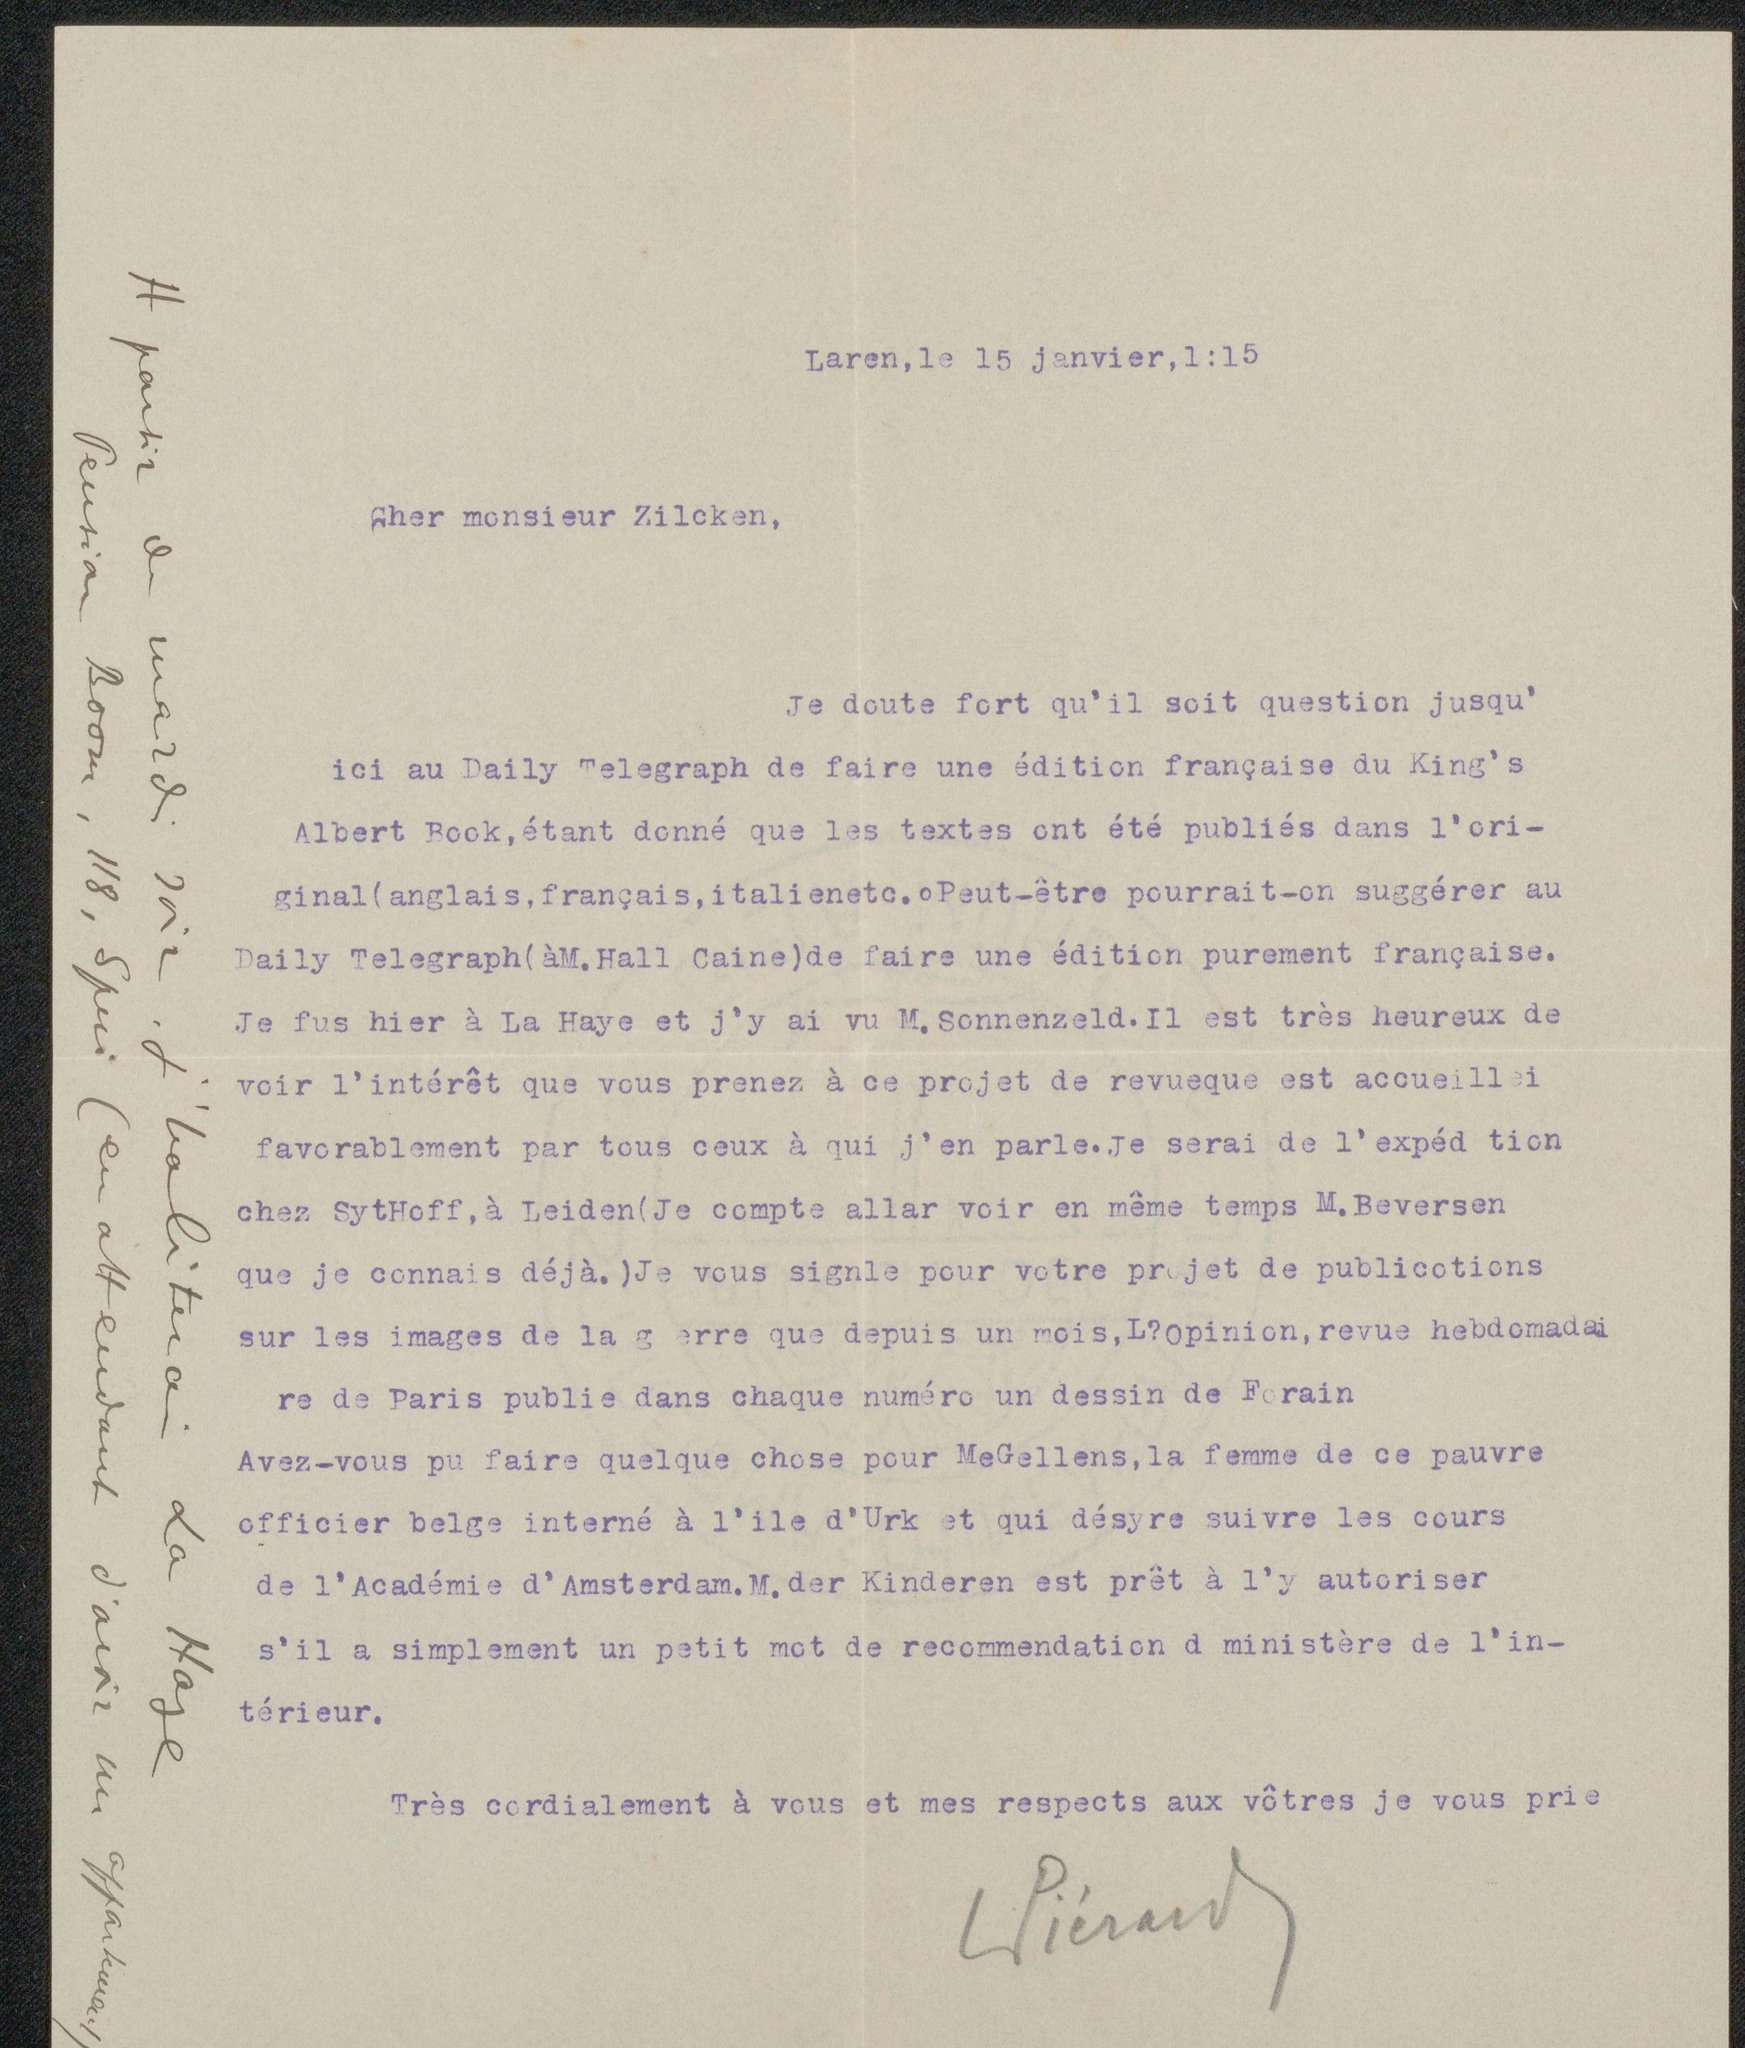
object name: letter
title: Brief aan Philip Zilcken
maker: louis piérard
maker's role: letterkundige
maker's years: 1886-1951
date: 1915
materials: ink, paper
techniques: pen, typewriting, writing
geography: laren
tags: den bosch, amsterdam, print maker, antoon derkinderen, leiden, publisher, albertus willem sijthoff, painter, draughtsman, philip zilcken, literature ~ arts, the hague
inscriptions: collector's mark: ‘RPK’, watermark